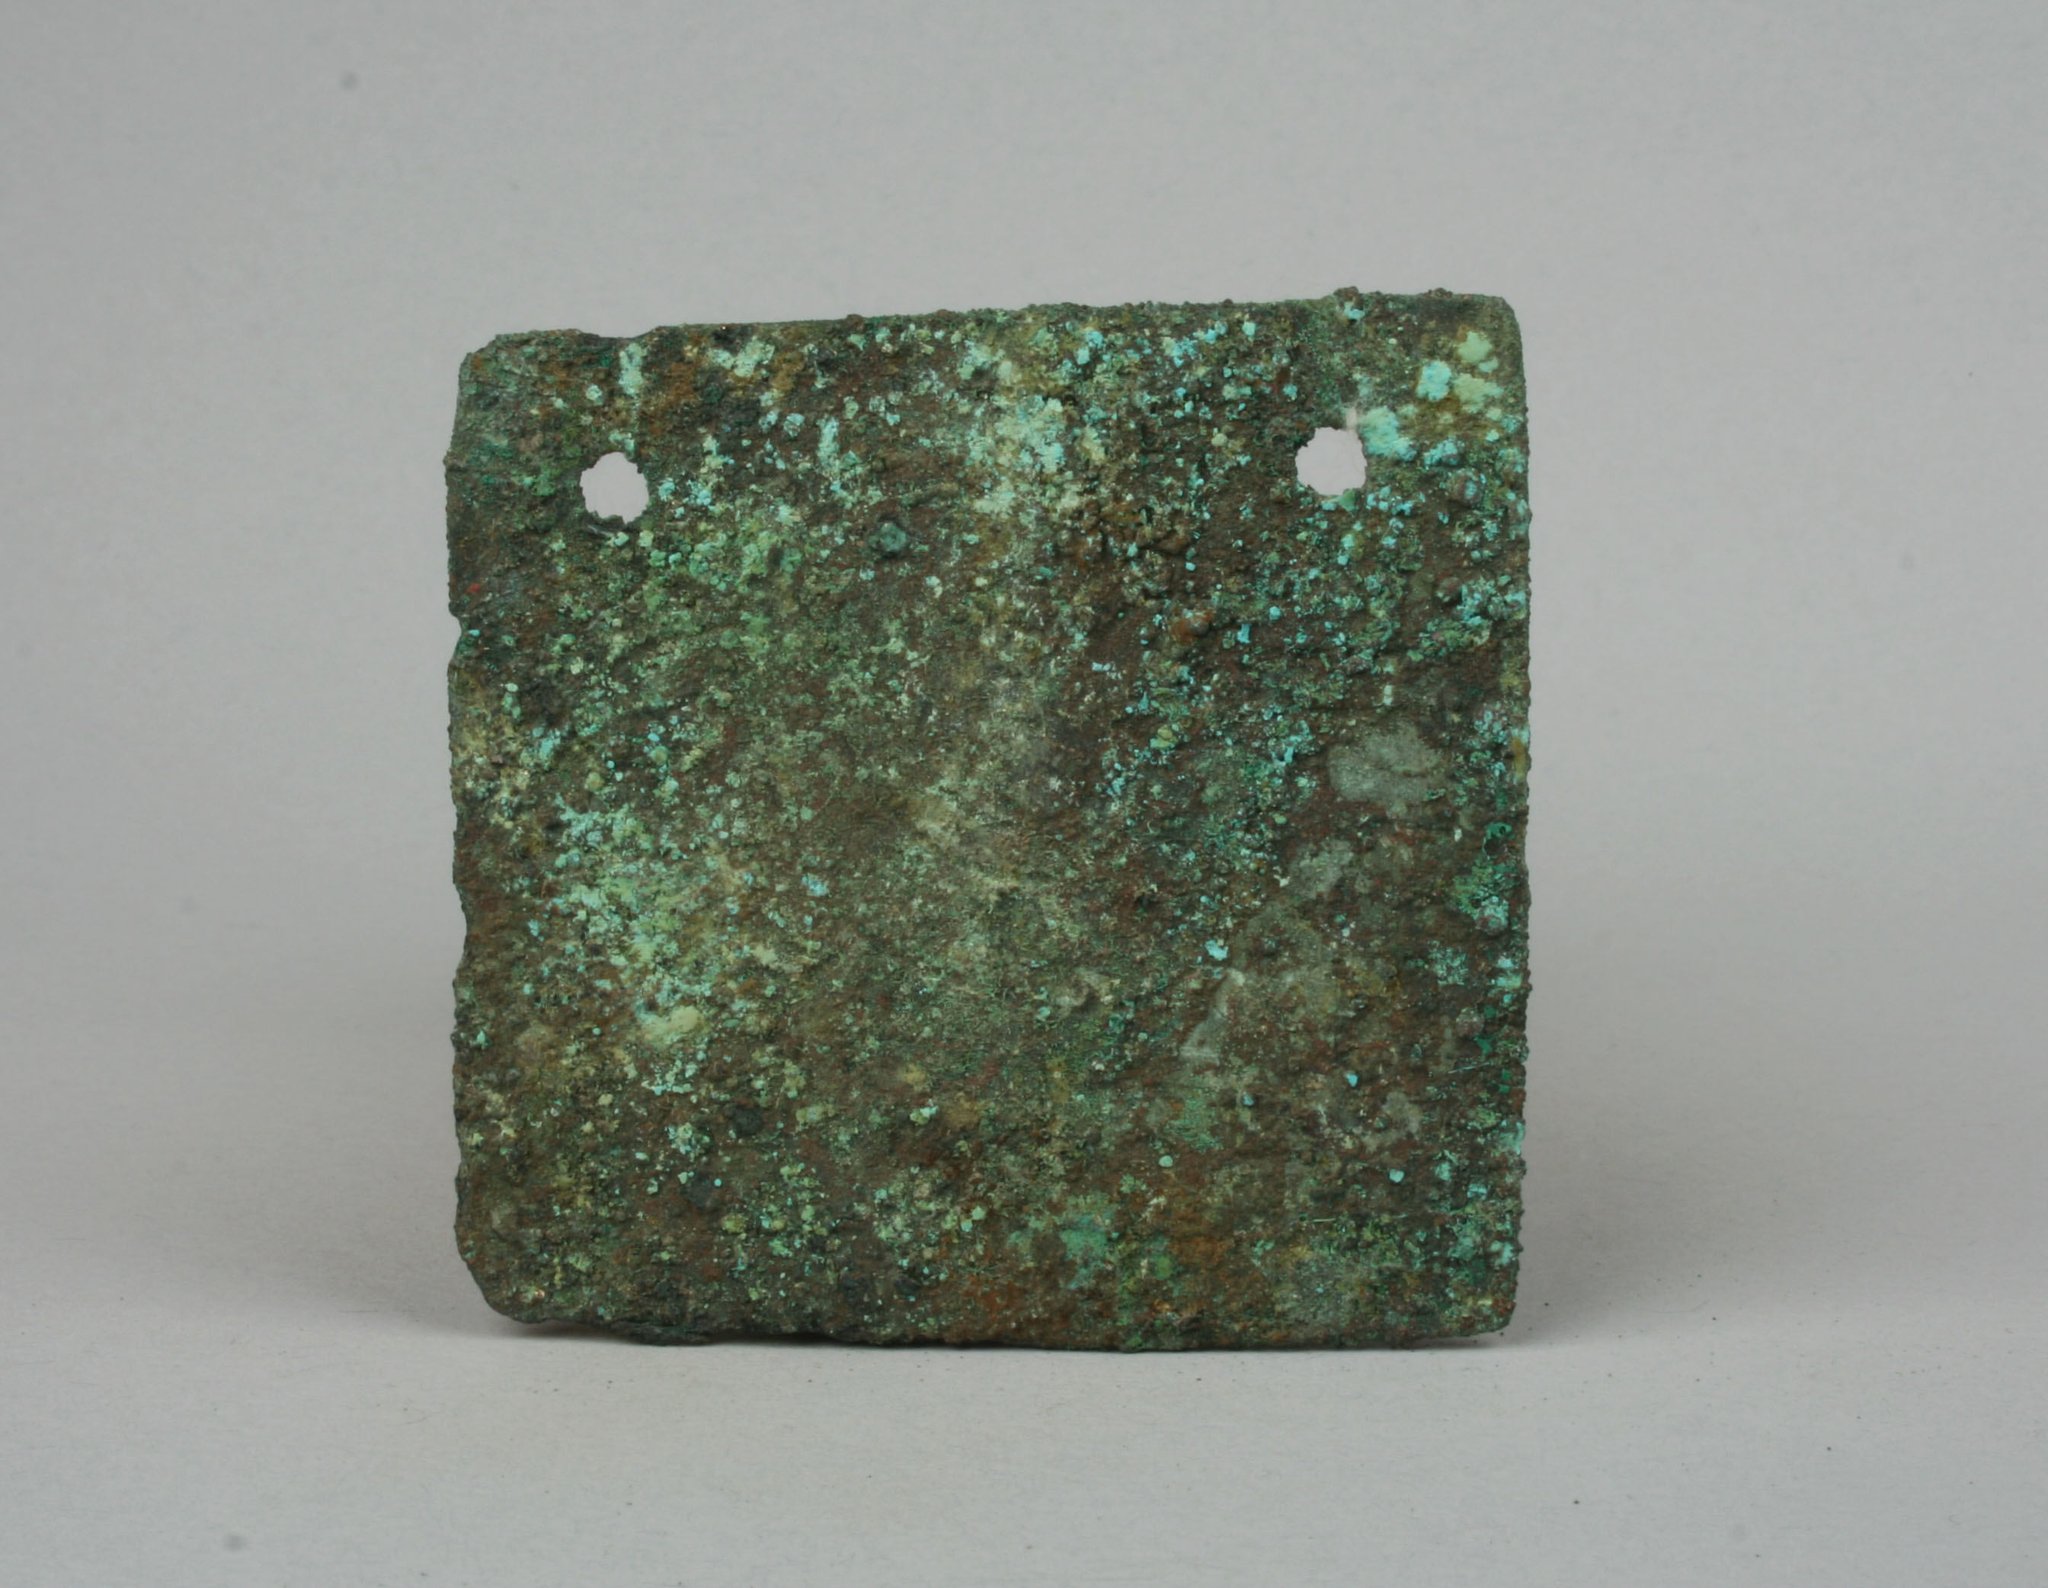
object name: ornament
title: Bird Plaque Ornament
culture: vicús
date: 300 BCE-200 CE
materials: copper, gilt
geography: peru